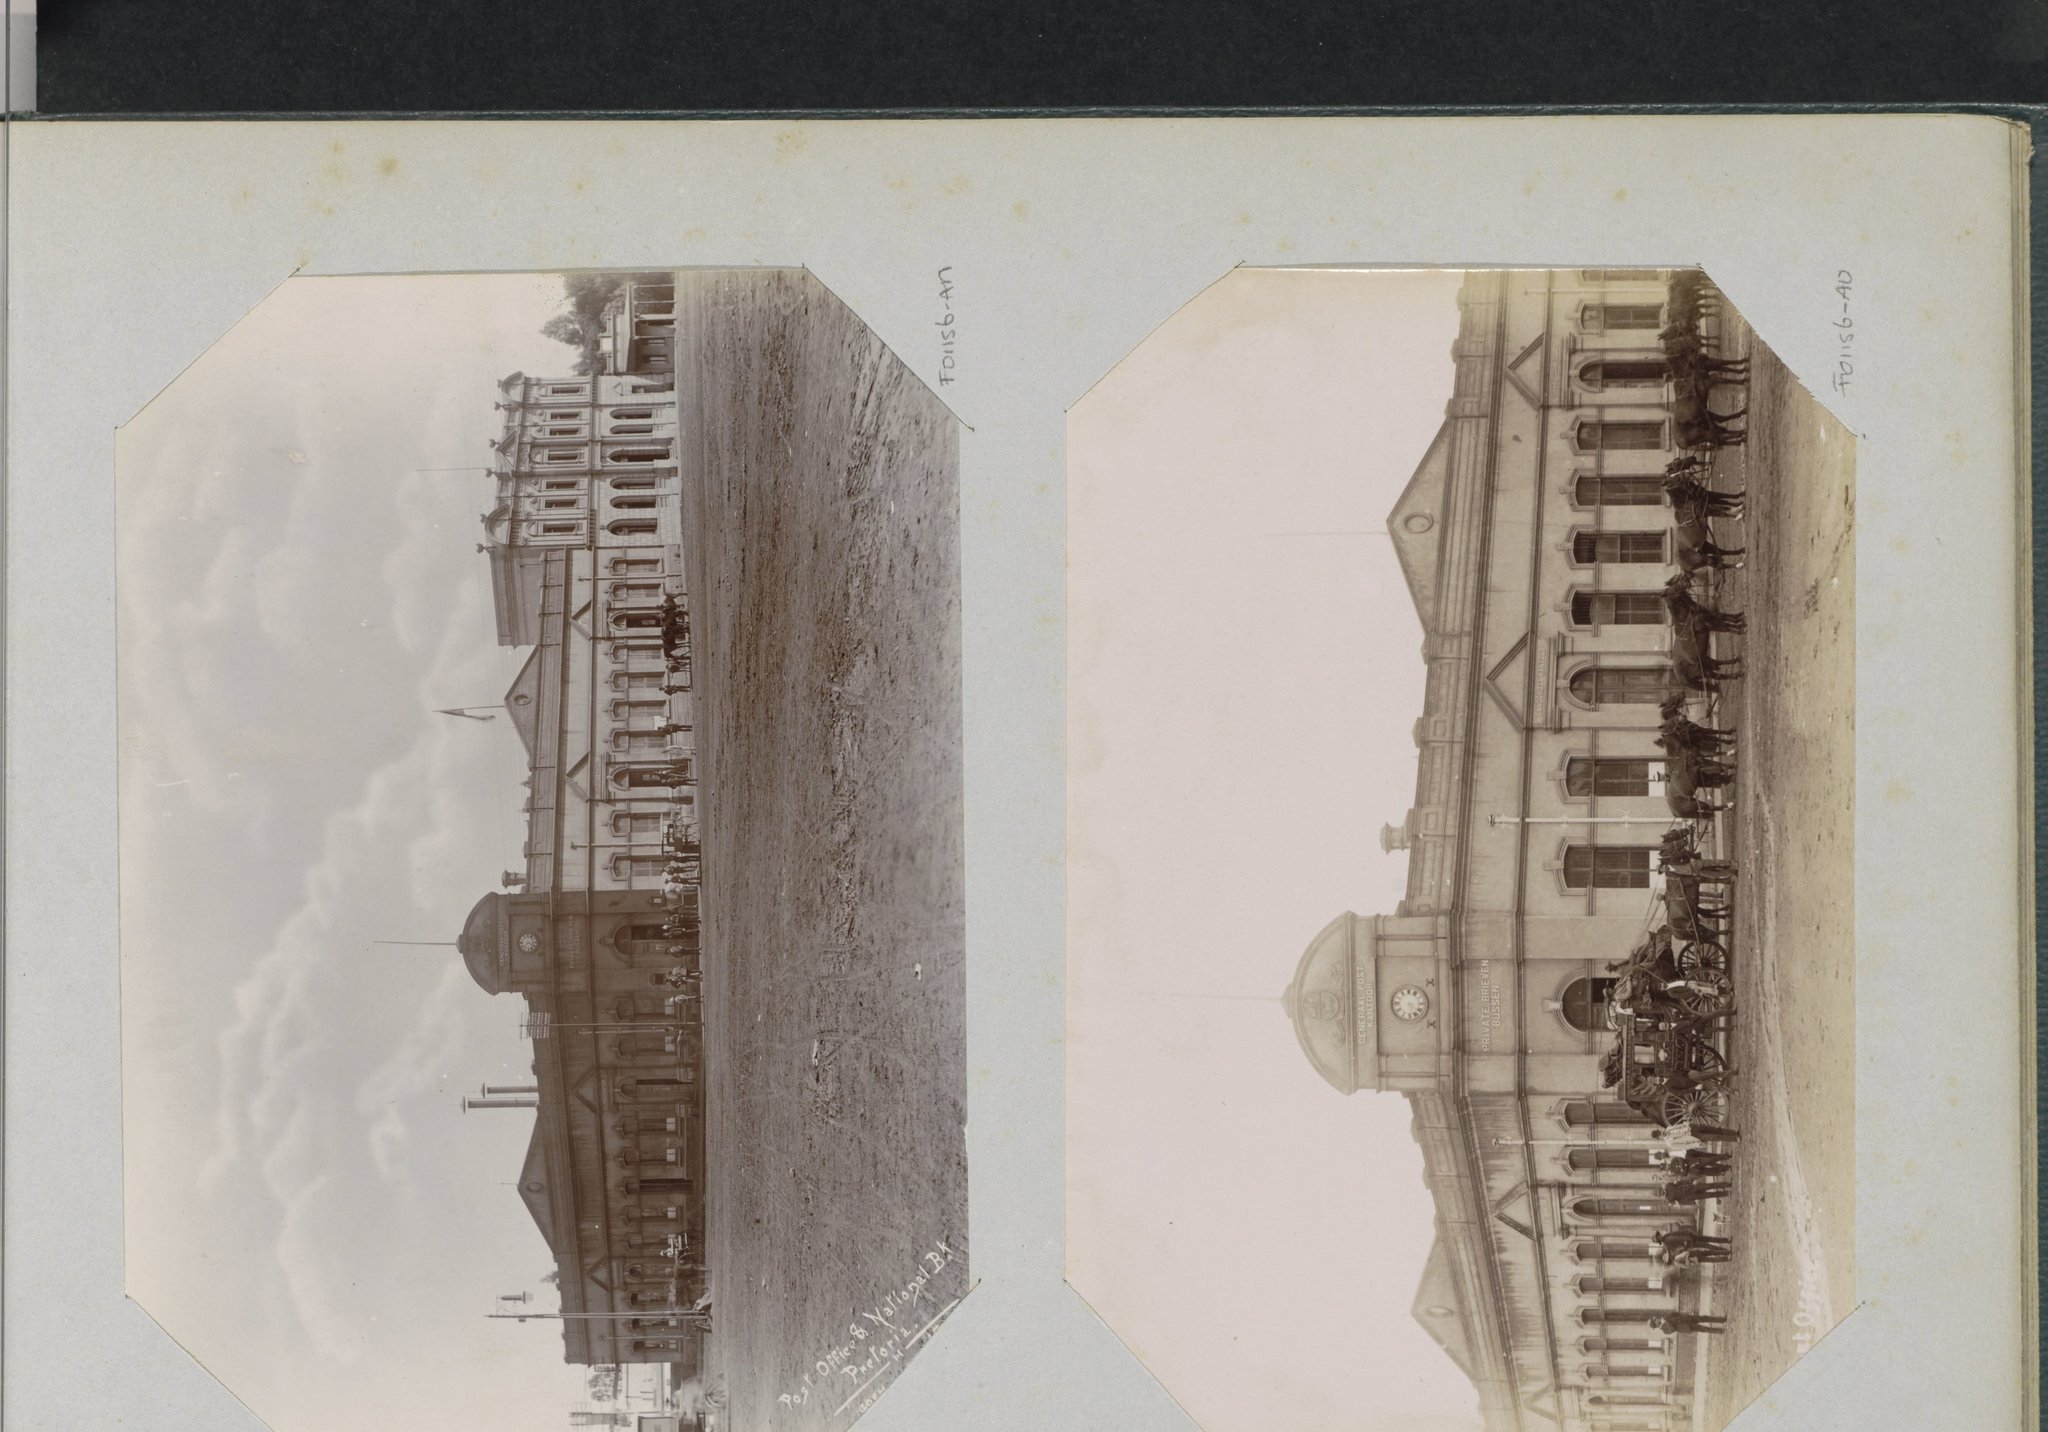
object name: album leaf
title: Gezicht op het postkantoor en bankgebouw te Pretoria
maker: james f. goch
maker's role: fotograaf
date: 1896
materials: photographic support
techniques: gelatin silver print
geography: pretoria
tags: post-office, bank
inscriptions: annotation: ‘Pretoria, Potkantoor, nat. Bank, Postkantoor, mrt 11-20 1896’, inscription: ‘ost Office & National Bk/ Pretoria/ Goch No.19’